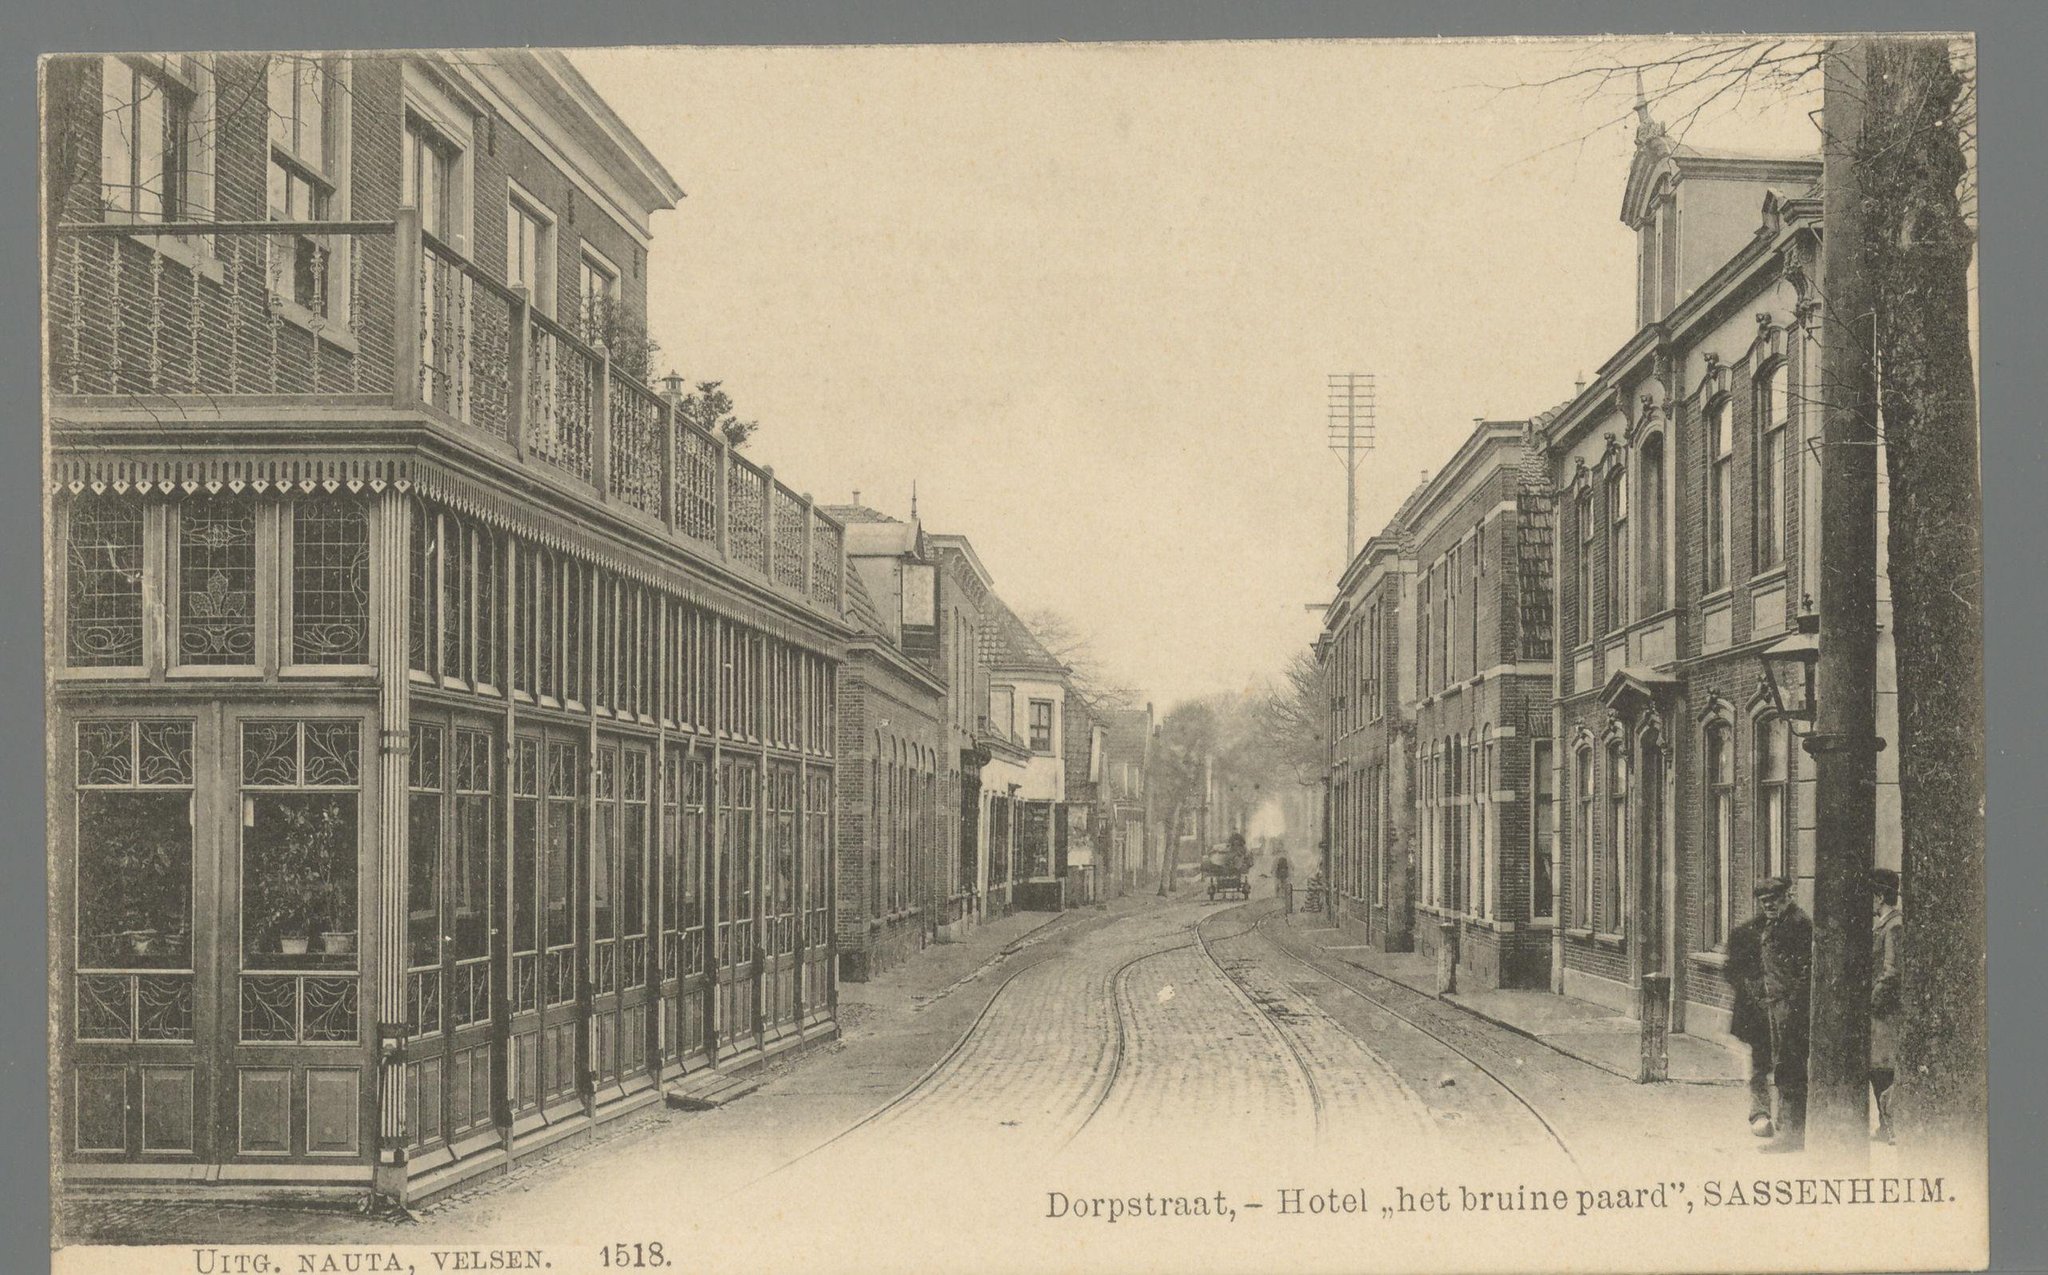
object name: ansichtkaart, prentbriefkaart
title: Dorpstraat, - Hotel "het bruine paard", Sassenheim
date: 1892-1905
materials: cardboard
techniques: photograph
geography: velsen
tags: street, hotel, hostelry, inn